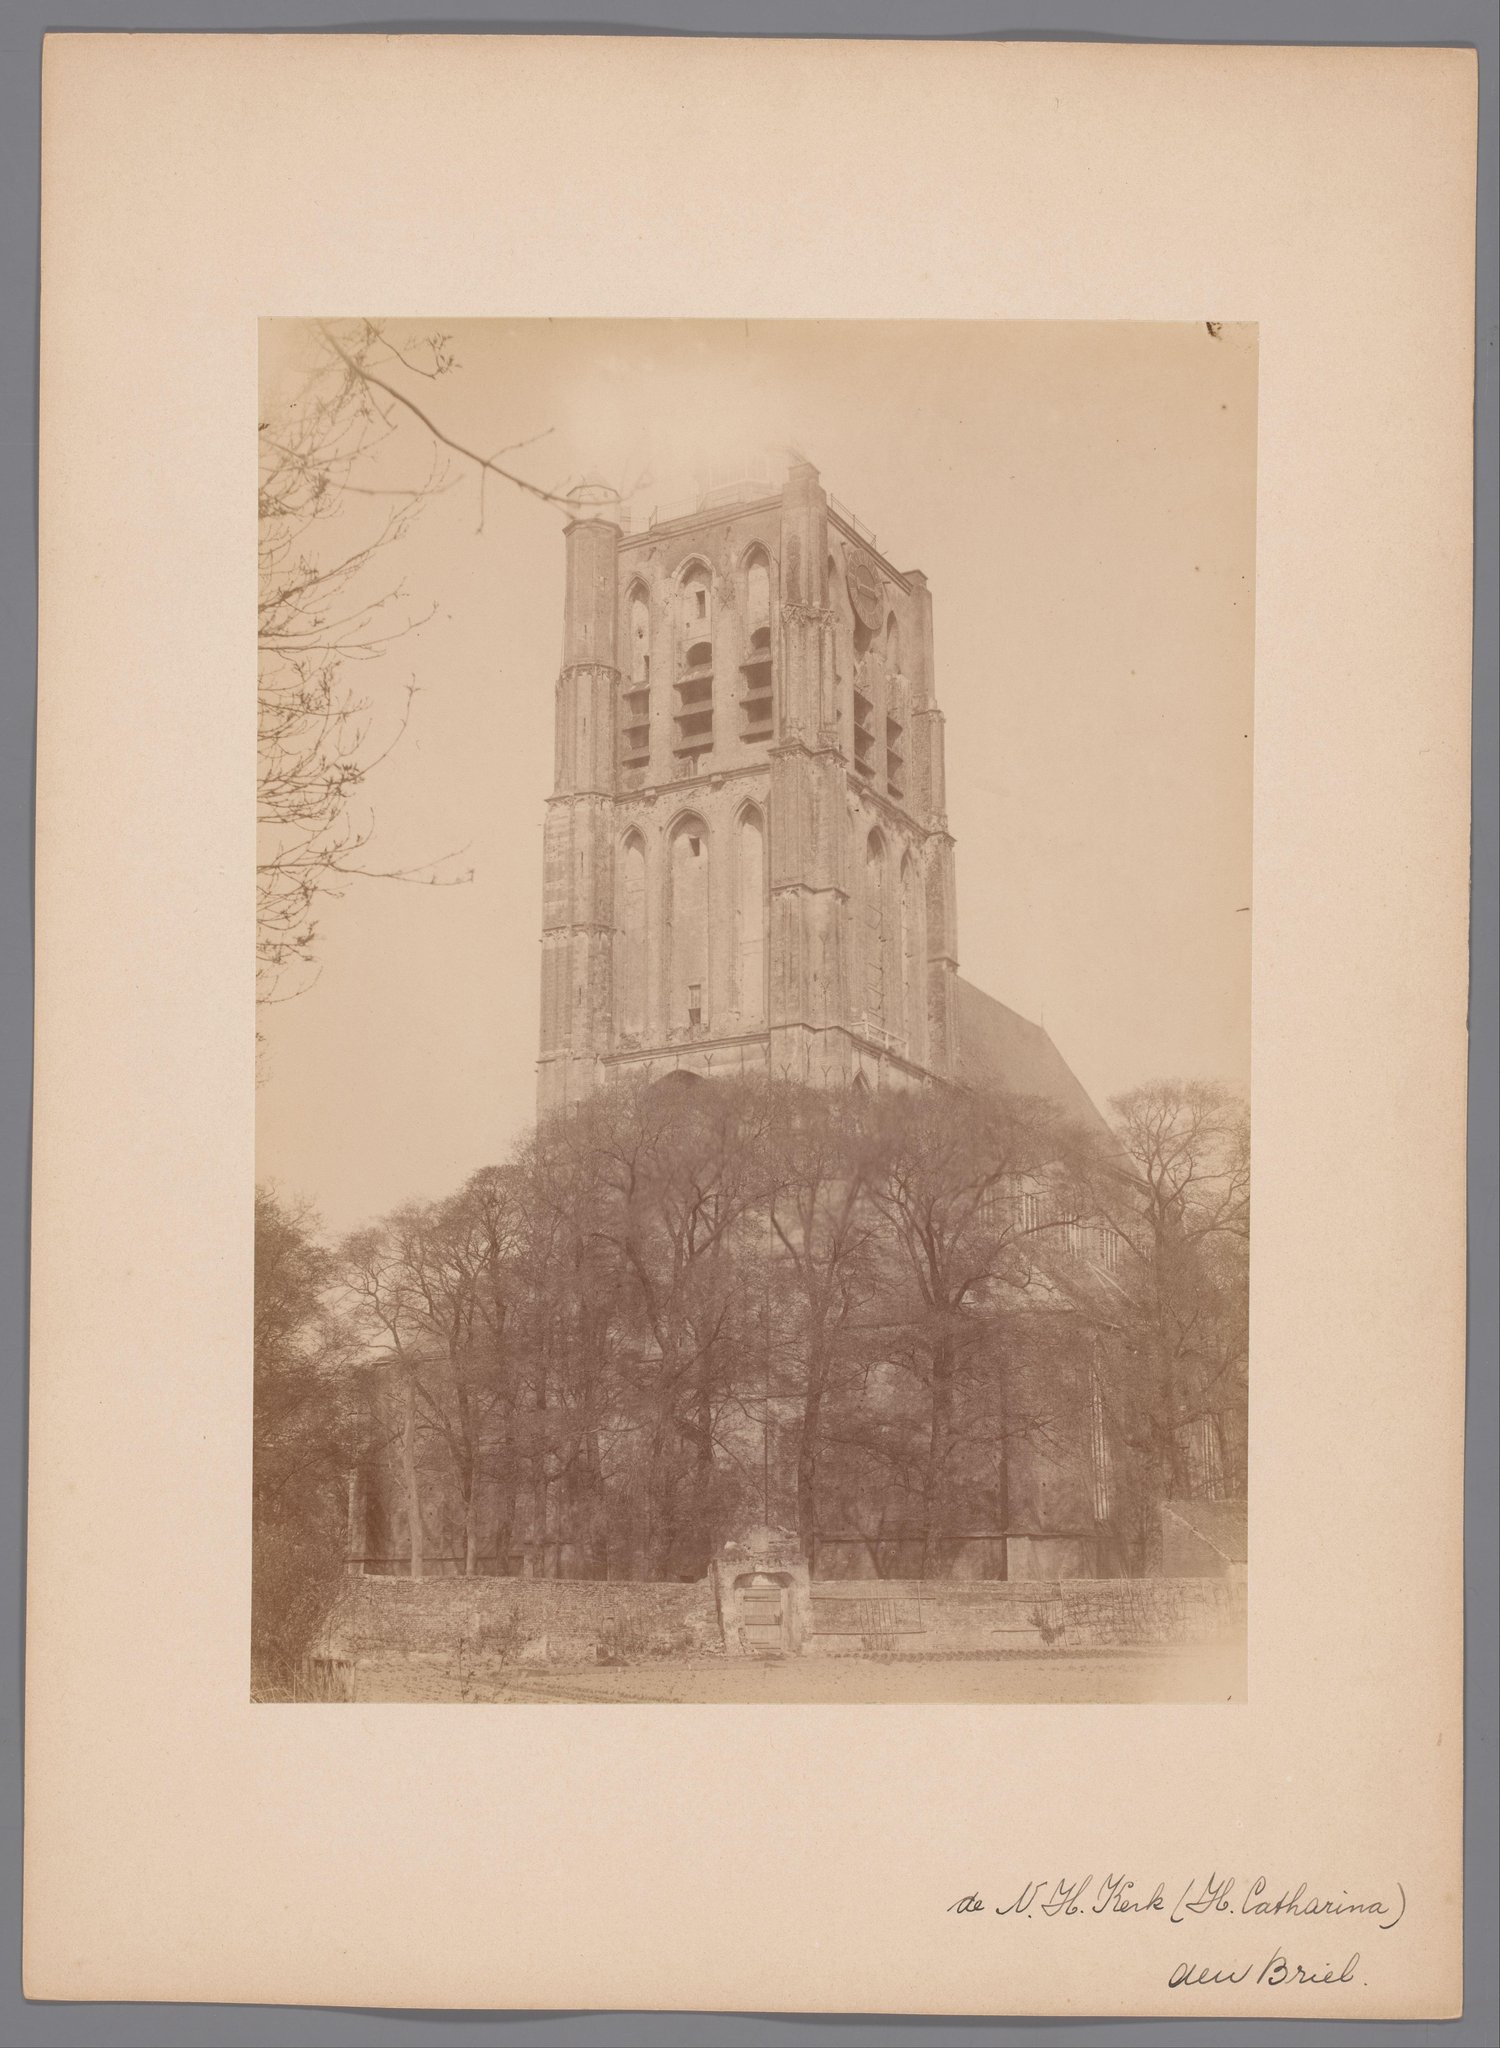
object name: photograph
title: Gezicht op de Grote of Sint-Catharijnekerk te Brielle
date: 1885-1905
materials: cardboard, photographic support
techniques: albumen print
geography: brielle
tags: church (exterior), tower (of house or building)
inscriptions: annotation: ‘Brielle/ N.H. Kerk’, annotation: ‘De N.H. Kerk (H. Catharina)/ Den Briel’